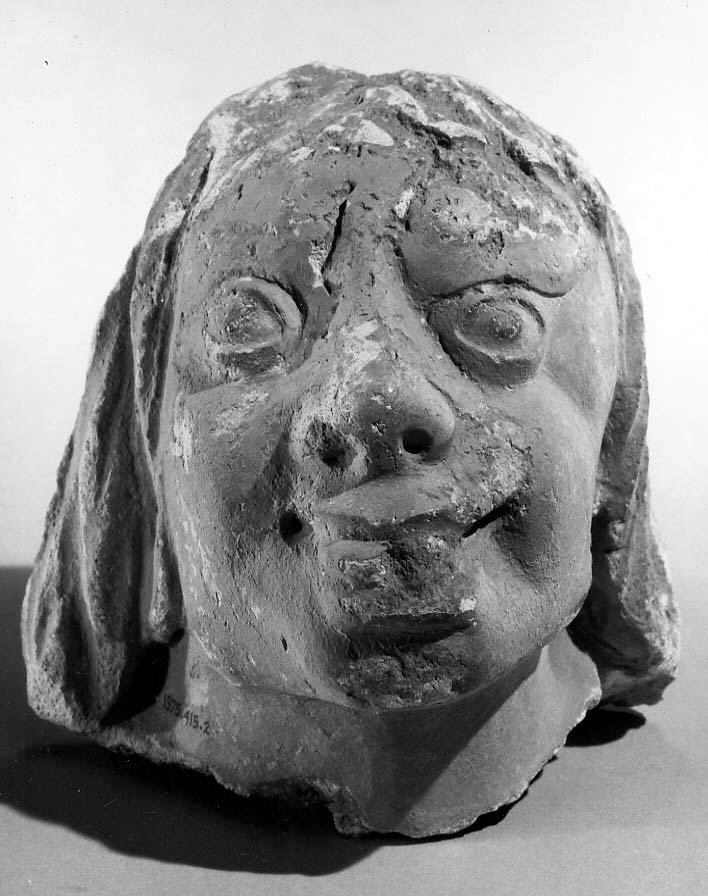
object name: head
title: Head of a Male Figure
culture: afghan, hadda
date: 301-500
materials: plaster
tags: gandharan,heads,men